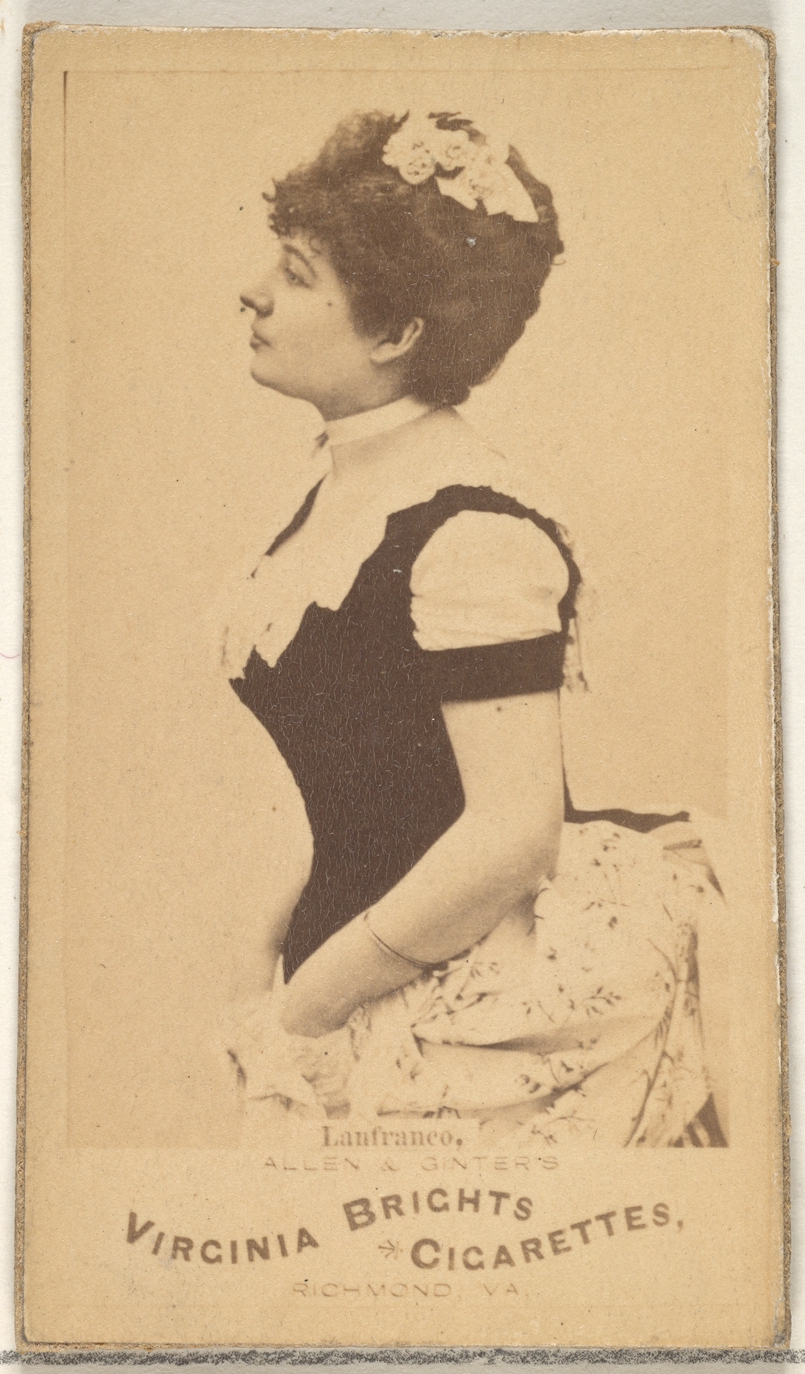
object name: photograph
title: Lanfranco, from the Actors and Actresses series (N45, Type 1) for Virginia Brights Cigarettes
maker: allen & ginter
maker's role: publisher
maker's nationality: american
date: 1888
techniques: albumen silver print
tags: women,actresses